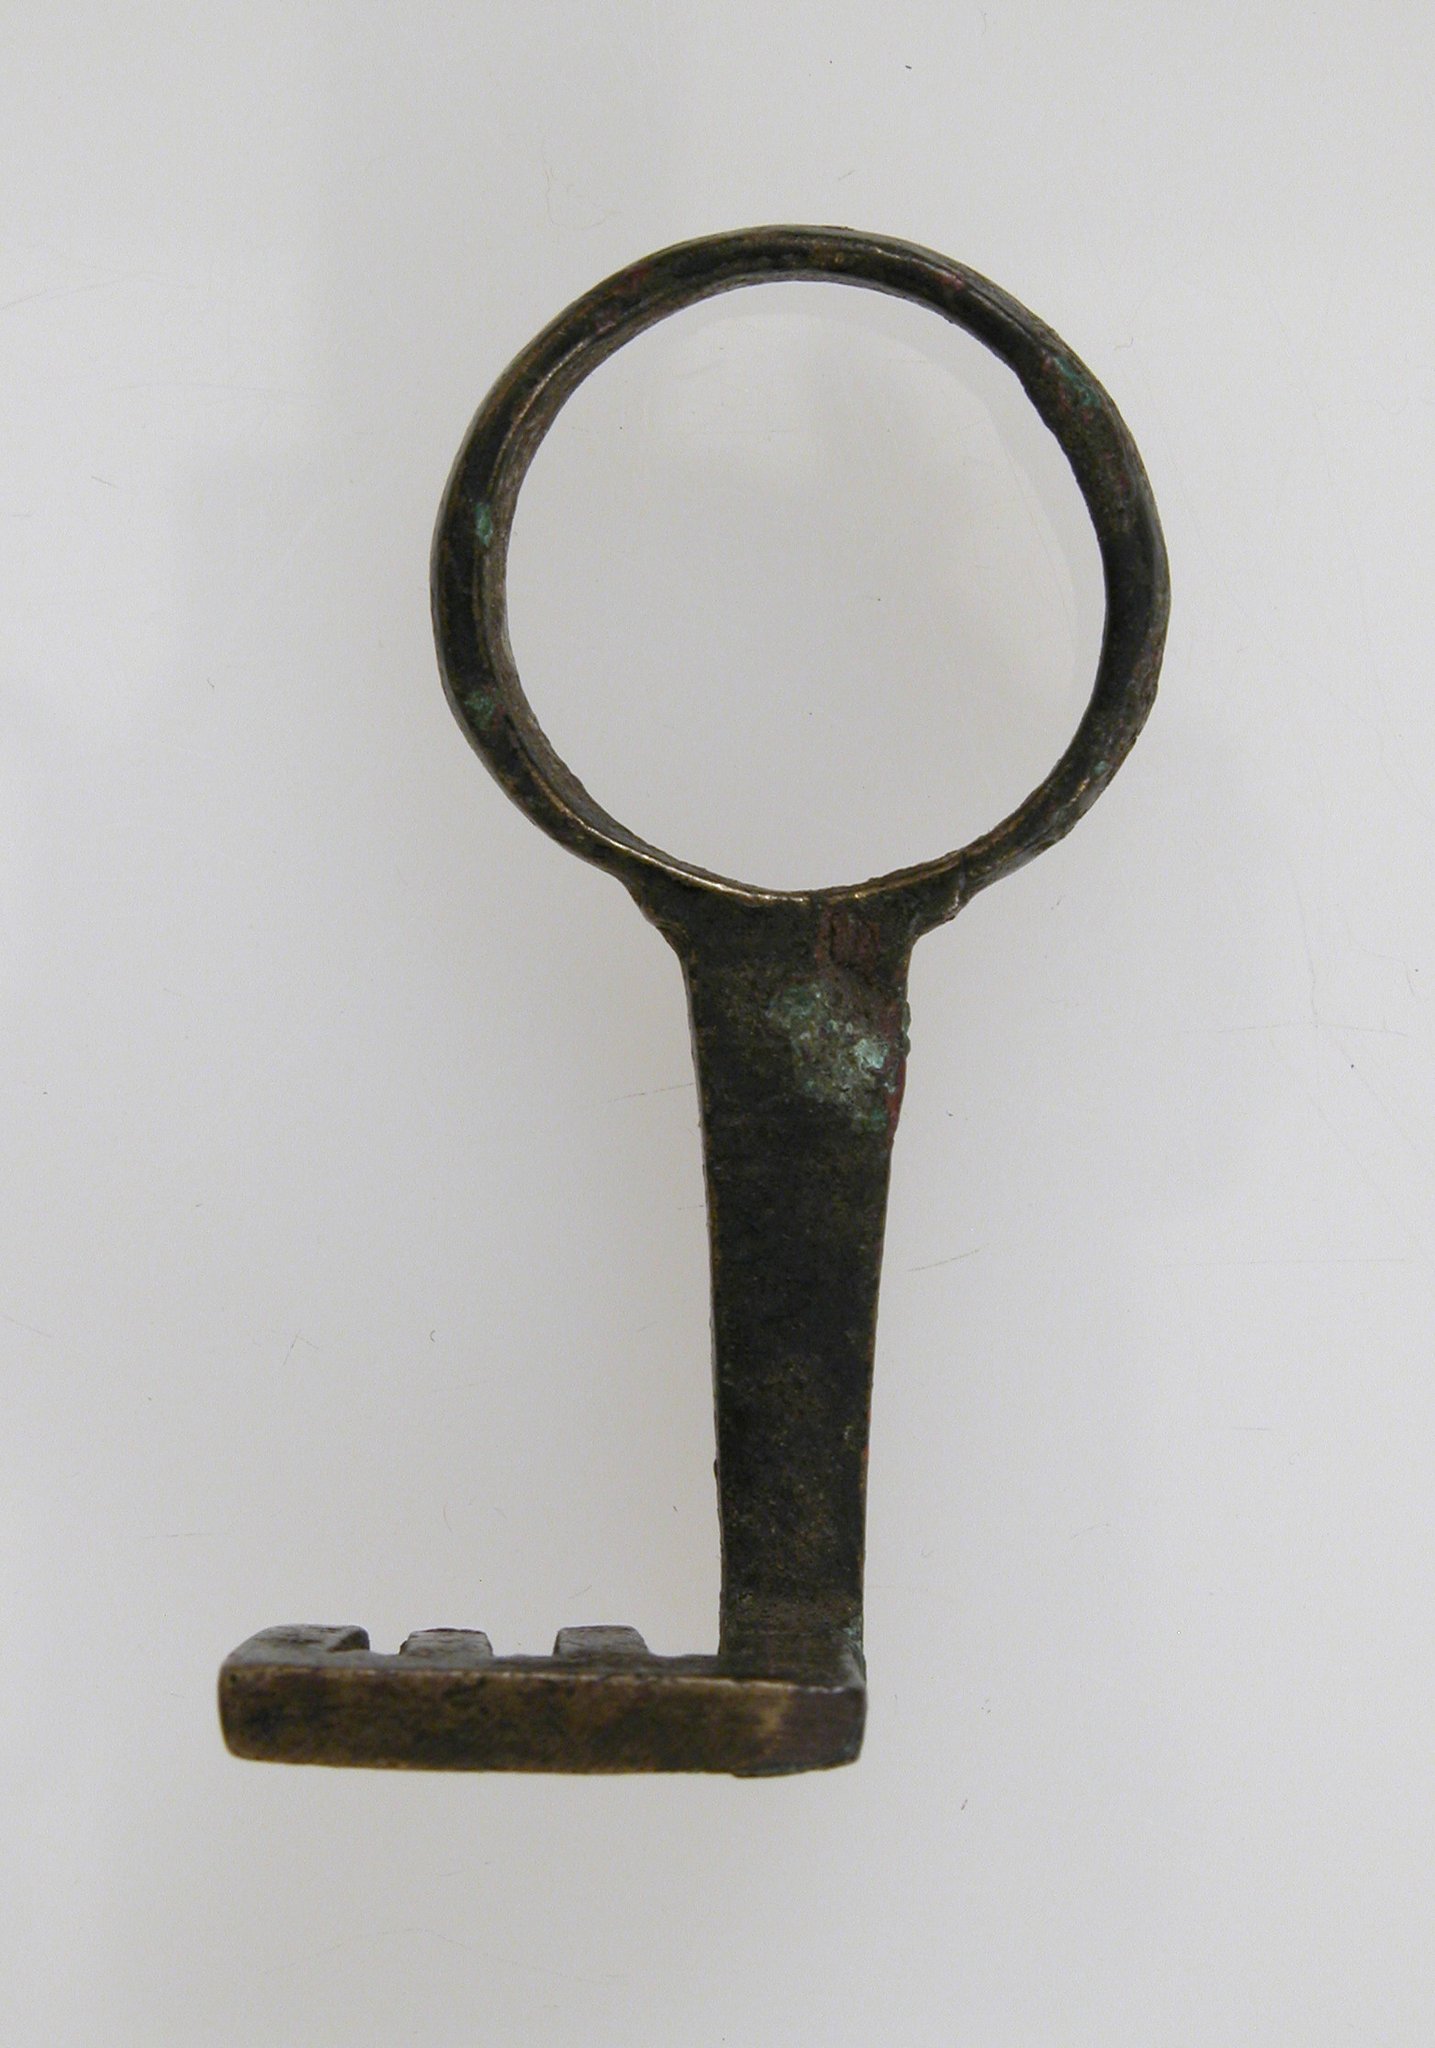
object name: key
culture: roman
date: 1-700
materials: copper alloy